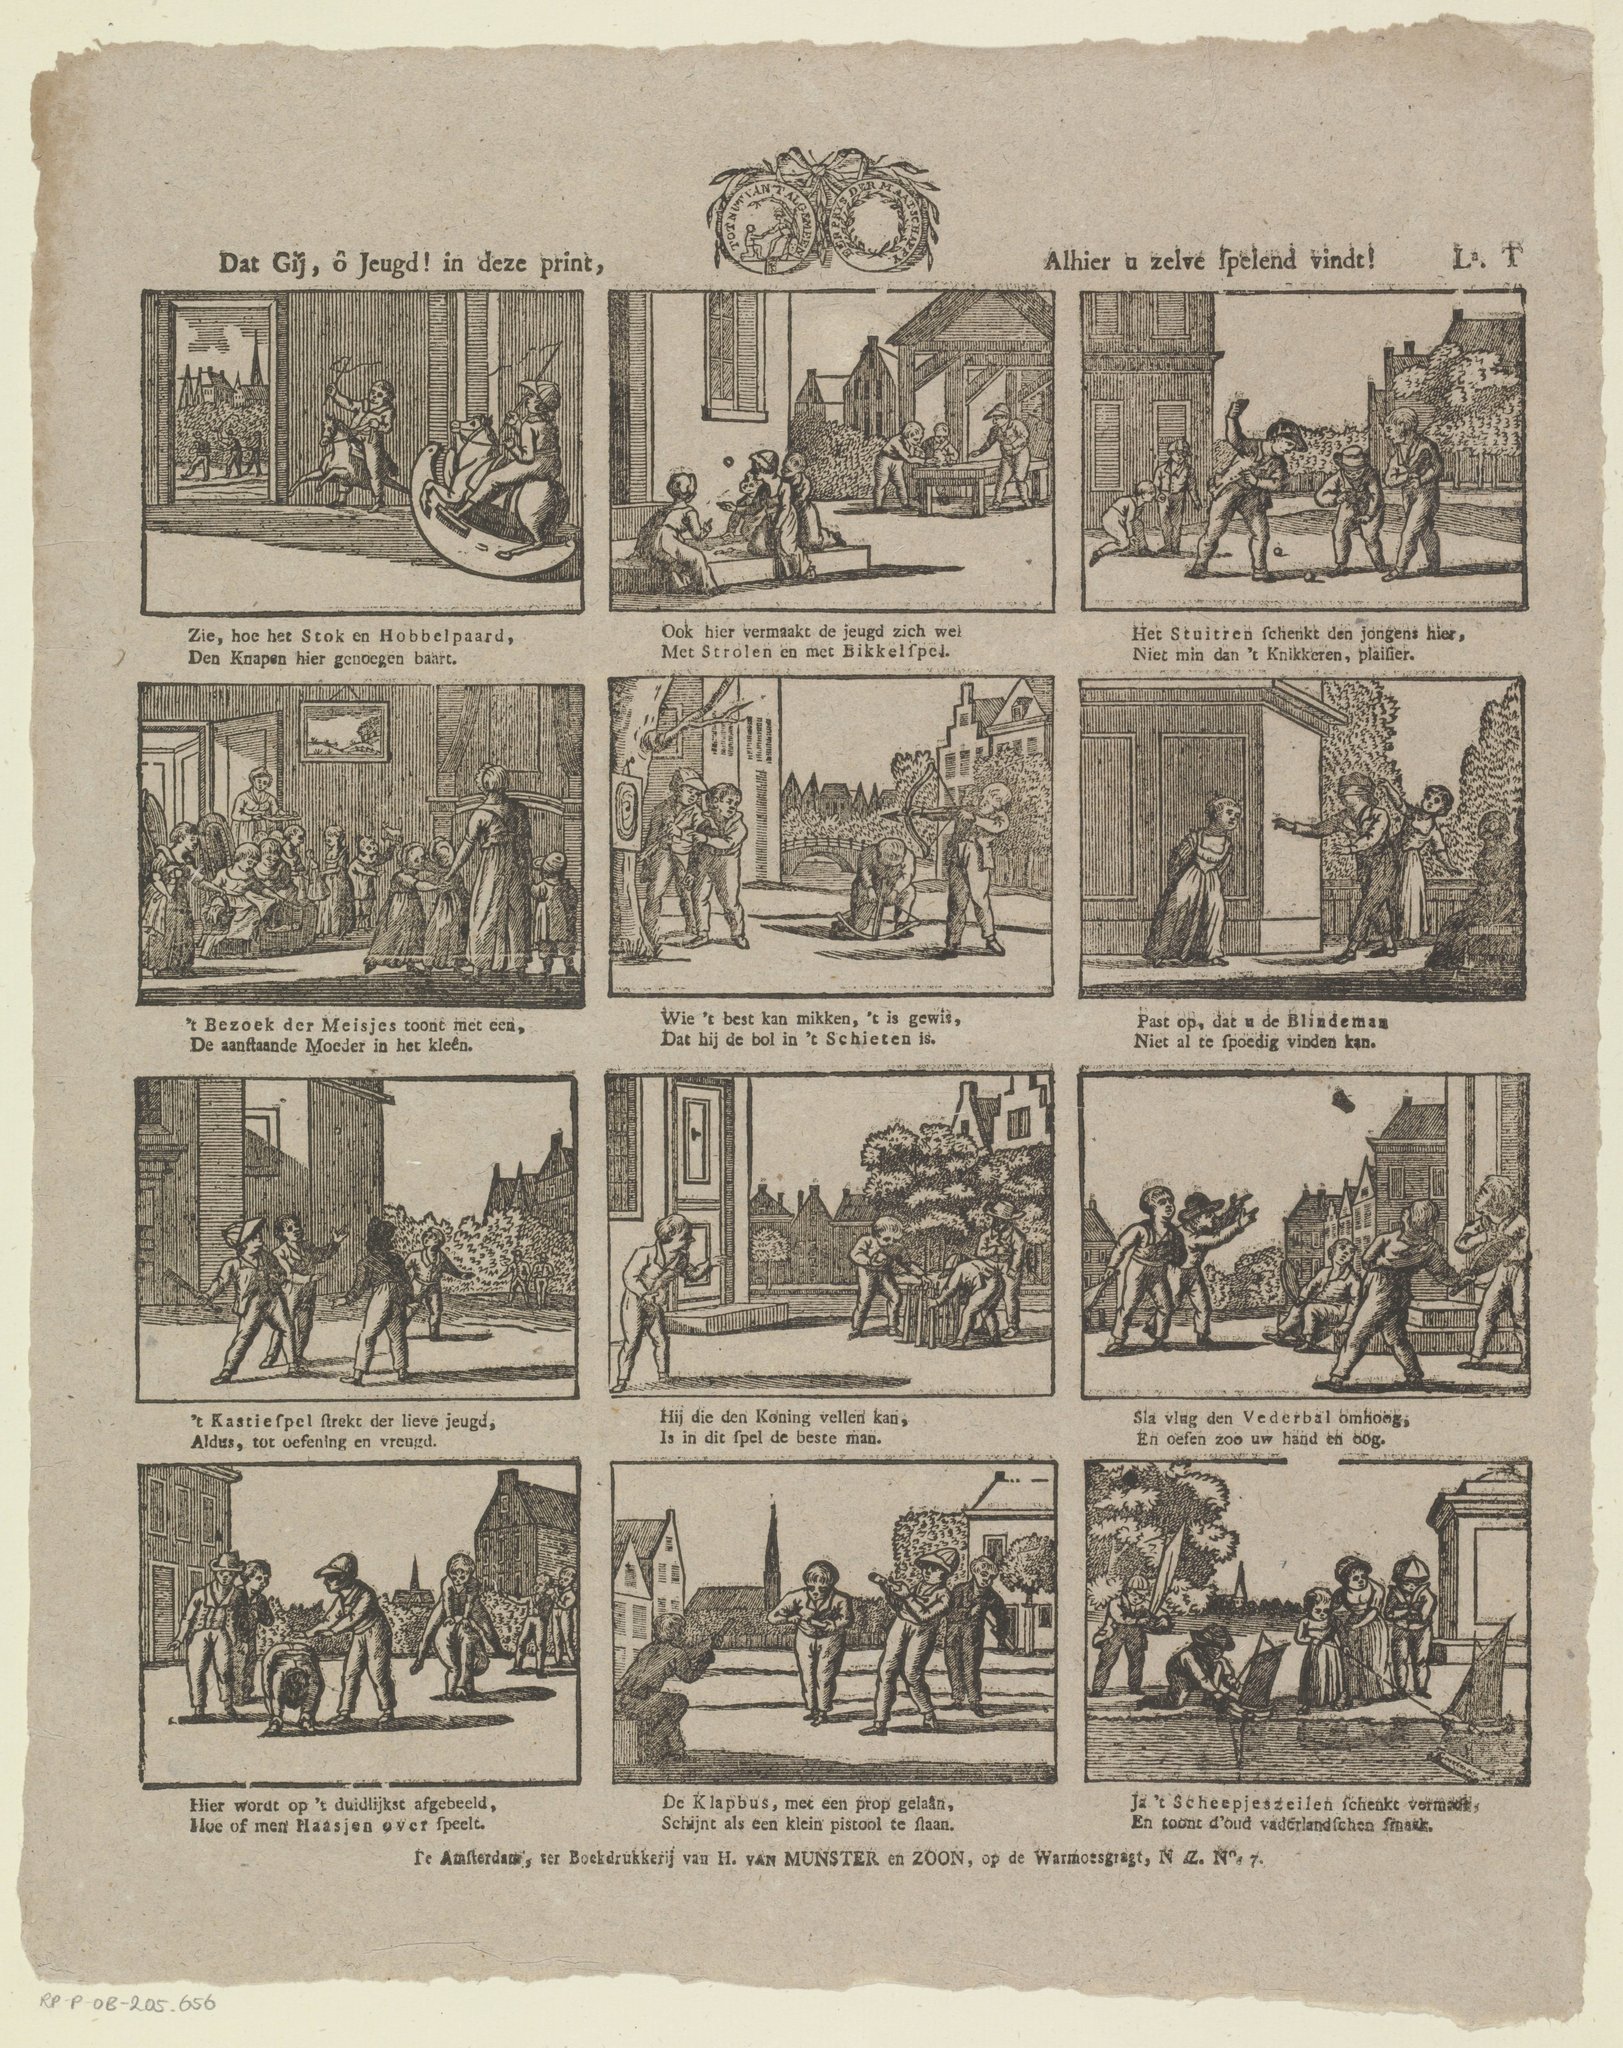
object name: print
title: Dat gij, ô jeugd! in deze print, / Alhier u zelve spelend vindt!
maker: gerrit oortman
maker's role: print maker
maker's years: 1781-1822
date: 1811-1829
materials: paper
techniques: letterpress printing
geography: amsterdam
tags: children's games and plays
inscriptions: collector's mark: Lugt 2760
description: Blad met 12 voorstellingen van kinderspelen. Midden boven het zegel van de Maatschappij tot Nut van 't Algemeen. Onder elke afbeelding een tweeregelig vers. Genummerd rechtsboven: L.T.